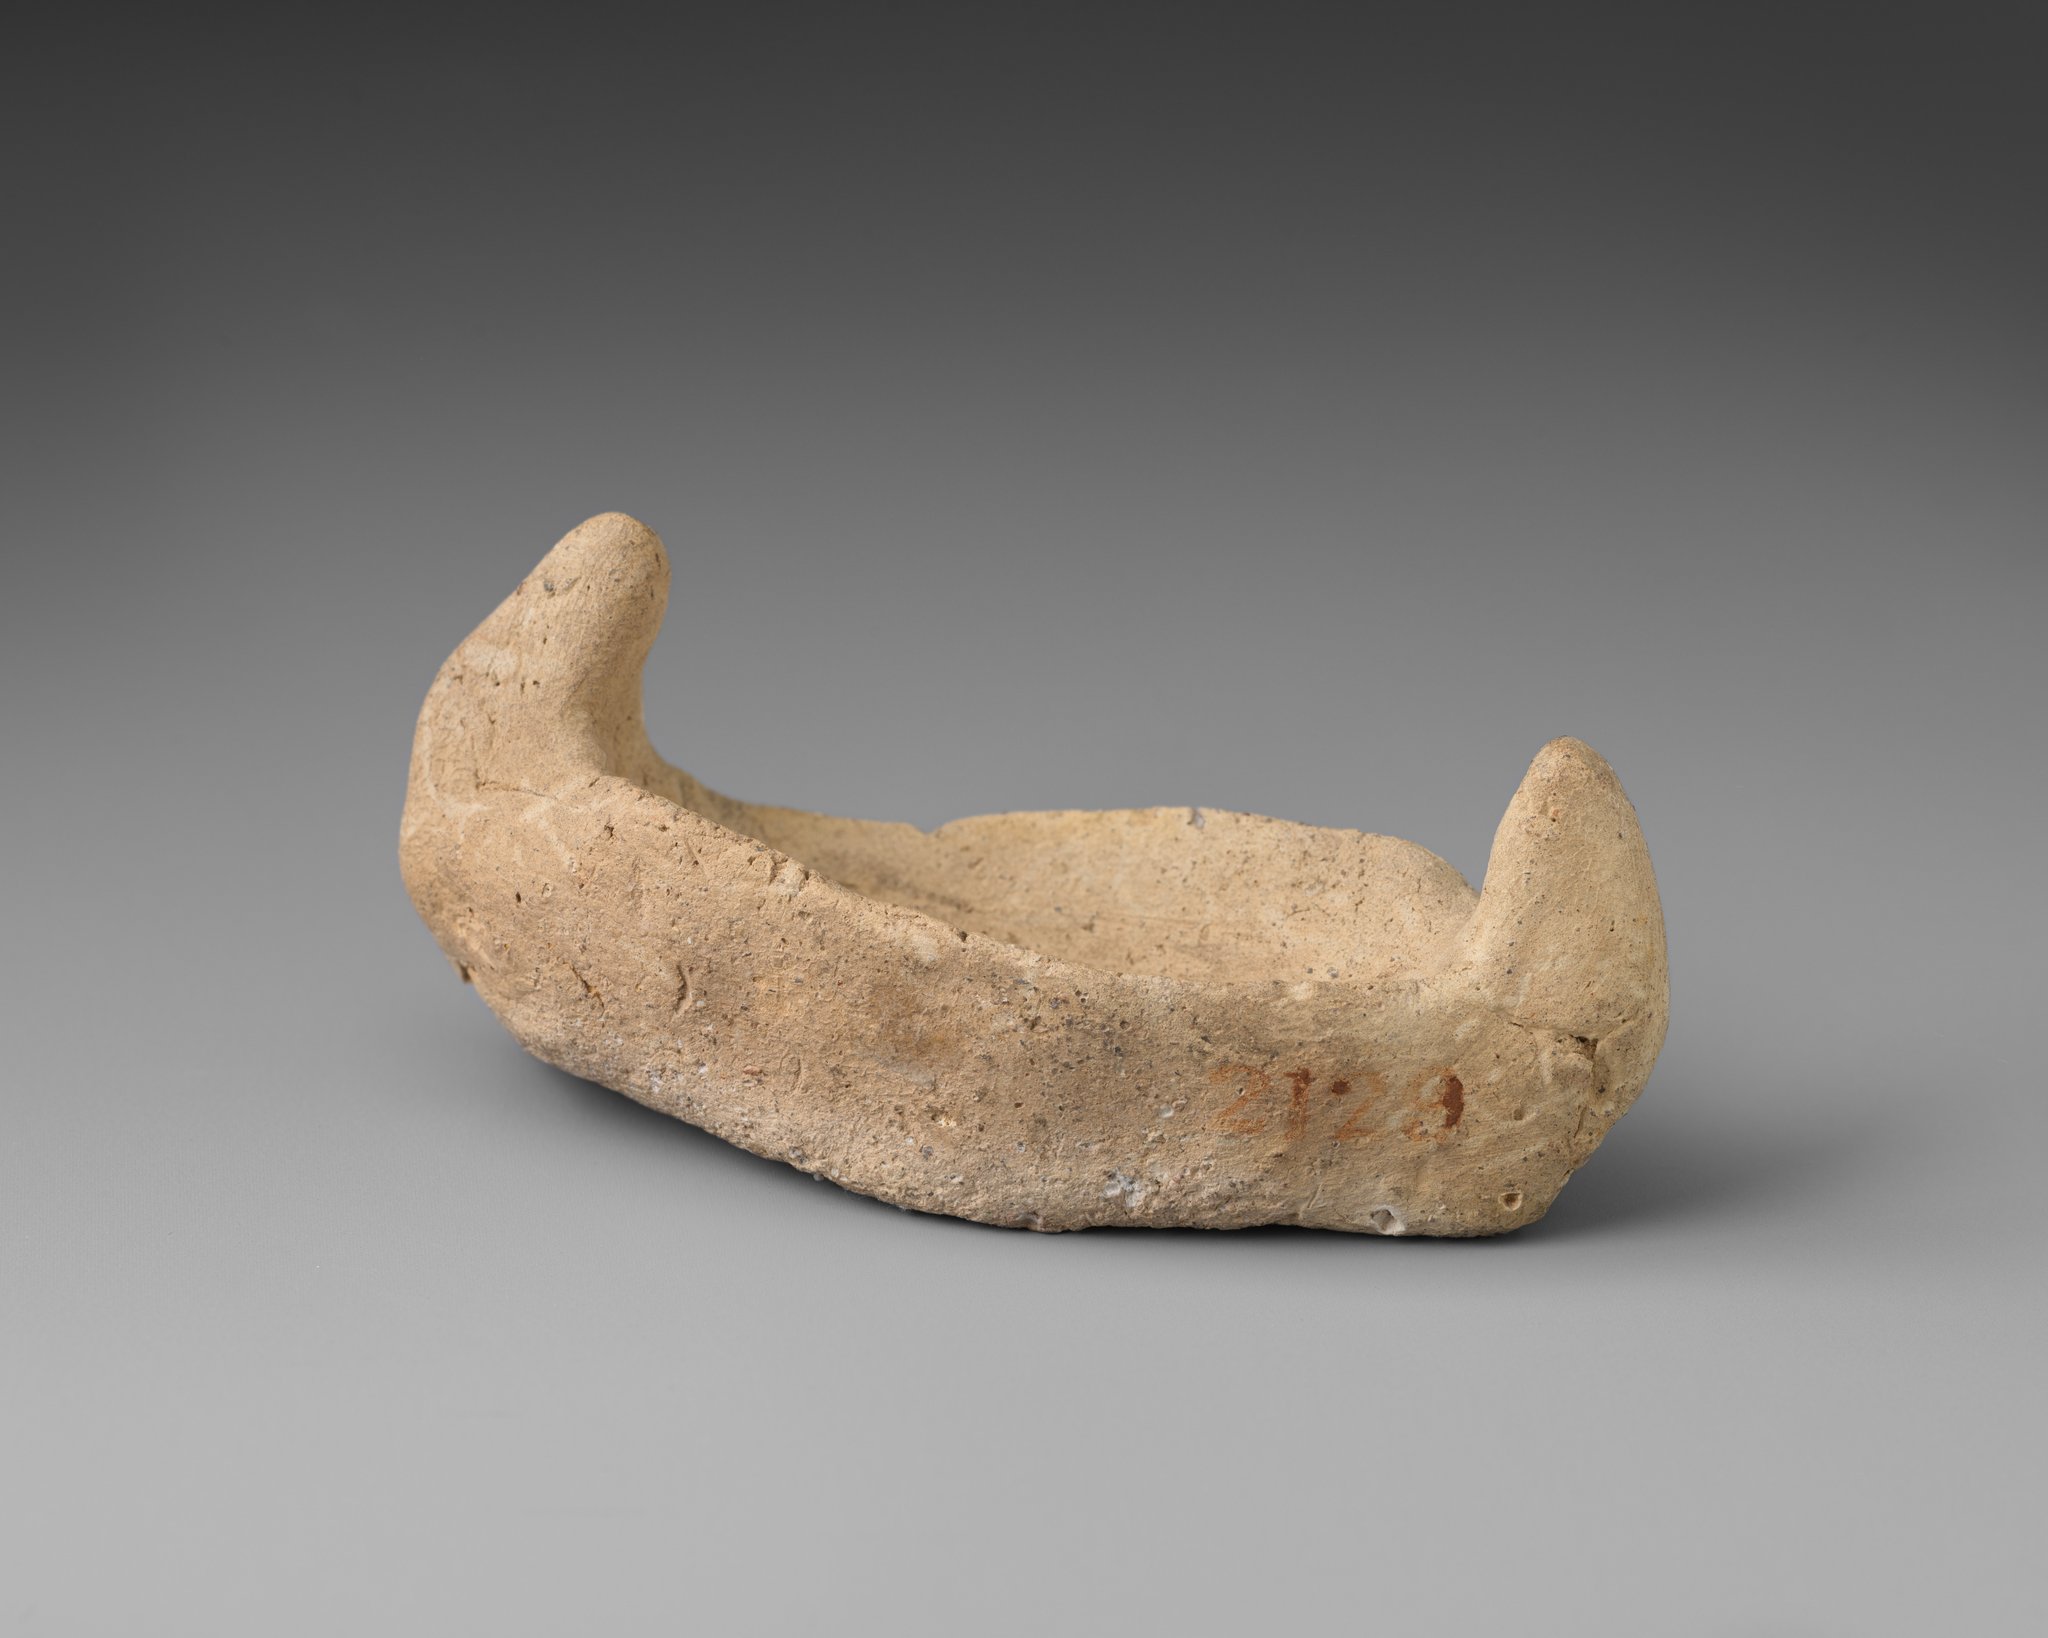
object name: model boat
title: Terracotta model of a boat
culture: cypriot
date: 600-480 BCE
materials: terracotta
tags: boats